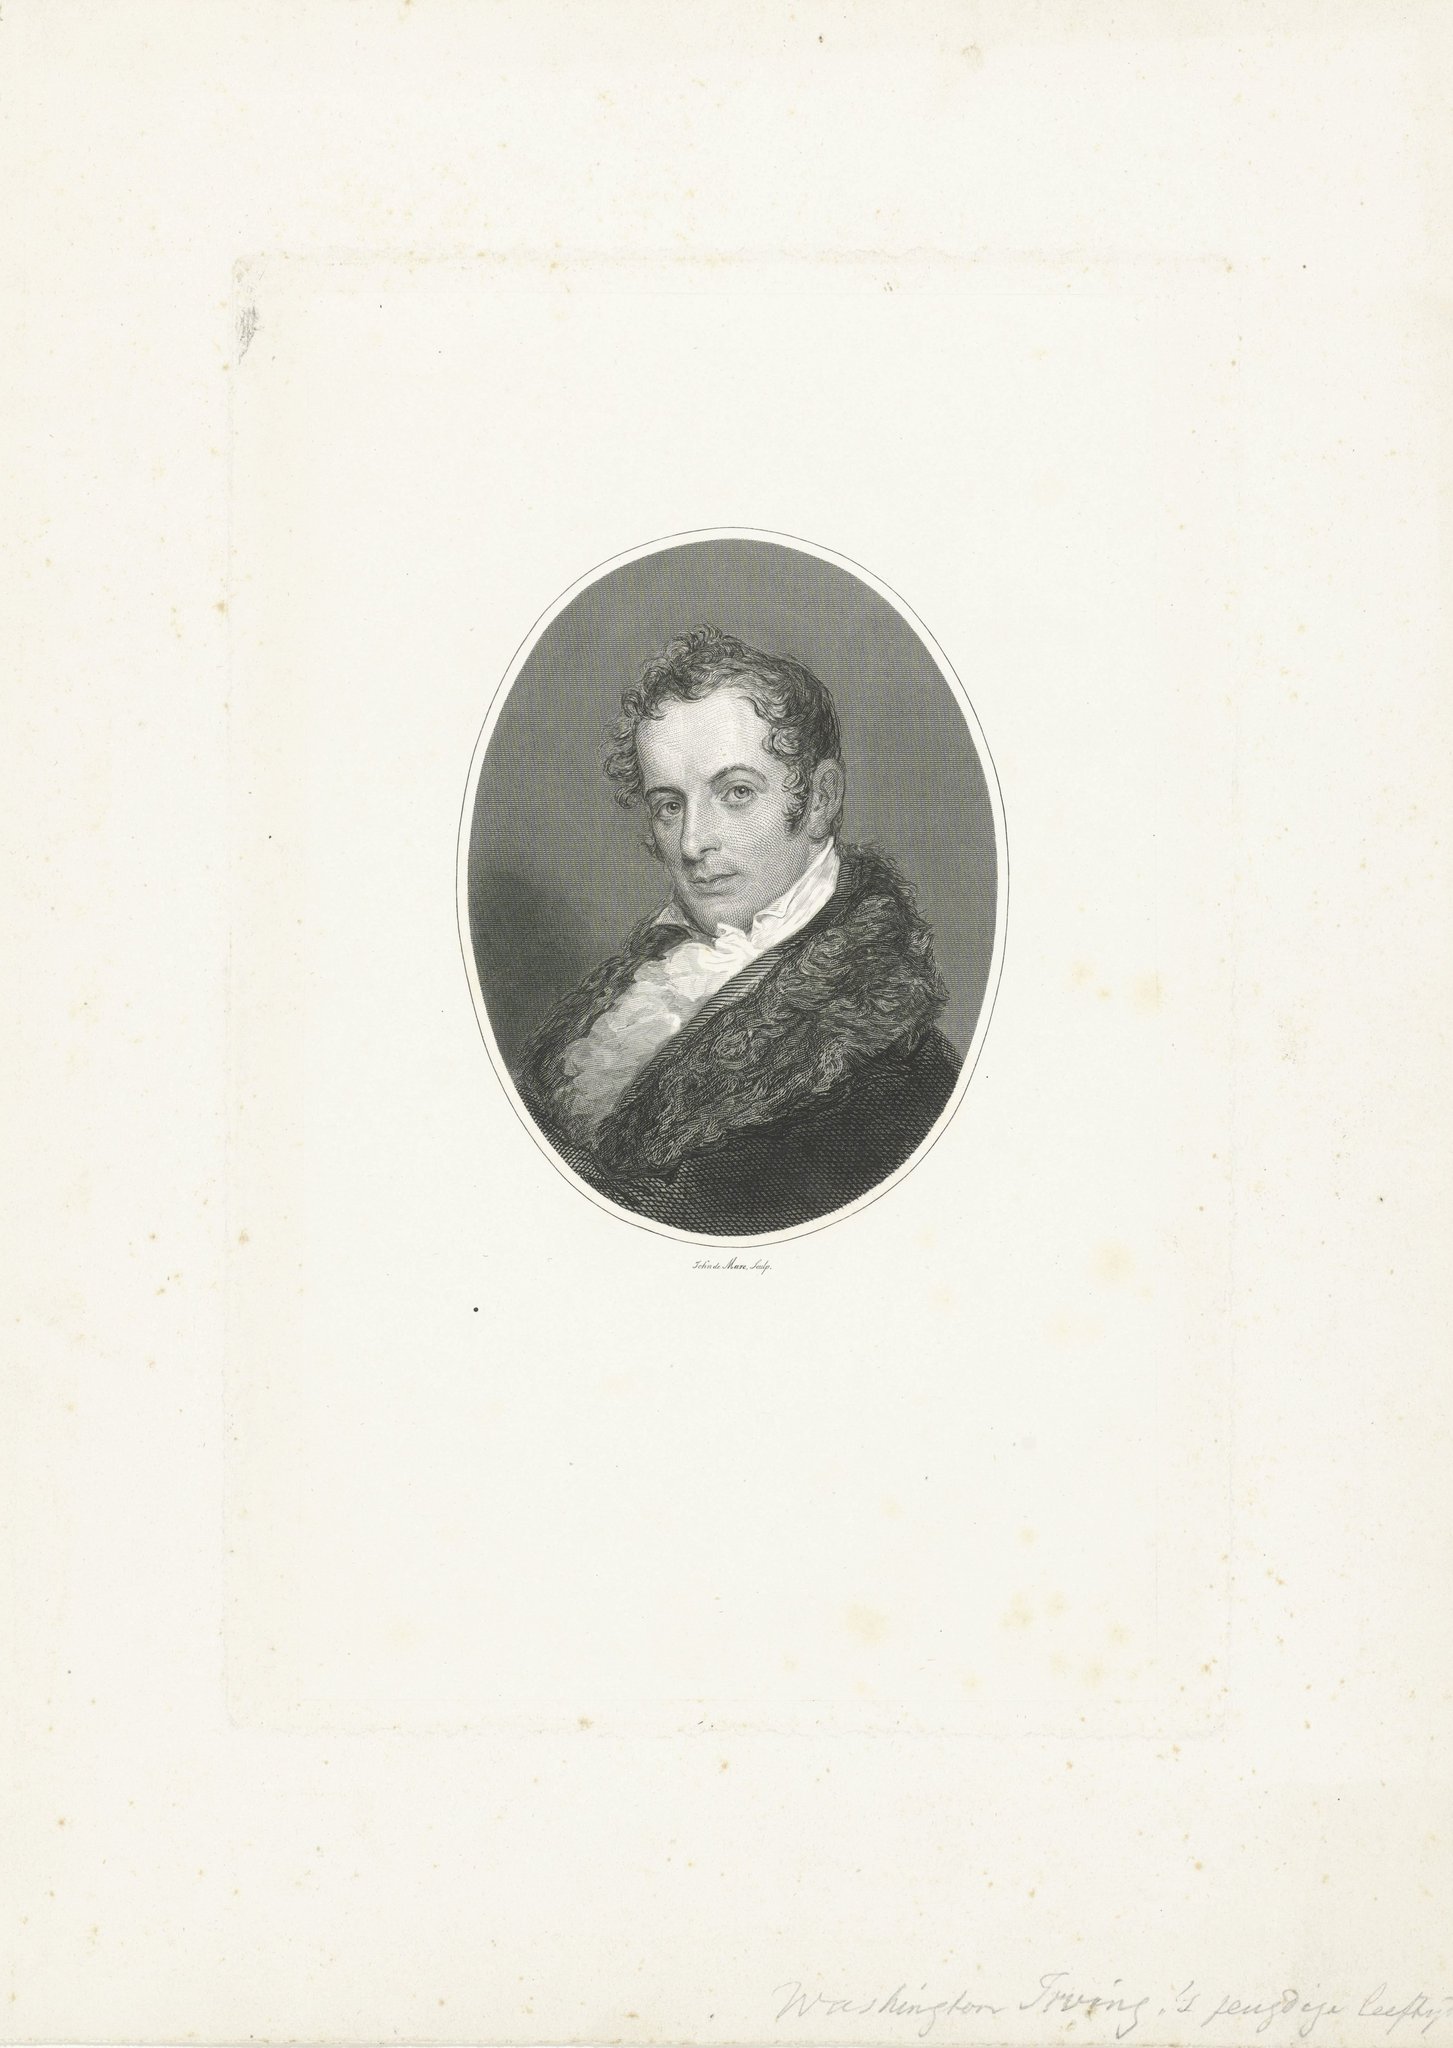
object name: print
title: Portret van Washington Irving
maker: johannes de mare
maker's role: draughtsman, print maker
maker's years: 1806-1889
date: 1816-1889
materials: paper, pencil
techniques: engraving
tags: washington irving, youth, adolescent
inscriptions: inscription: ‘Washington Irving 's jeugdige leeftijd’, collector's mark: Lugt 2228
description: Portret van de Amerikaanse schrijver Washington Irving op jeugdige leeftijd.